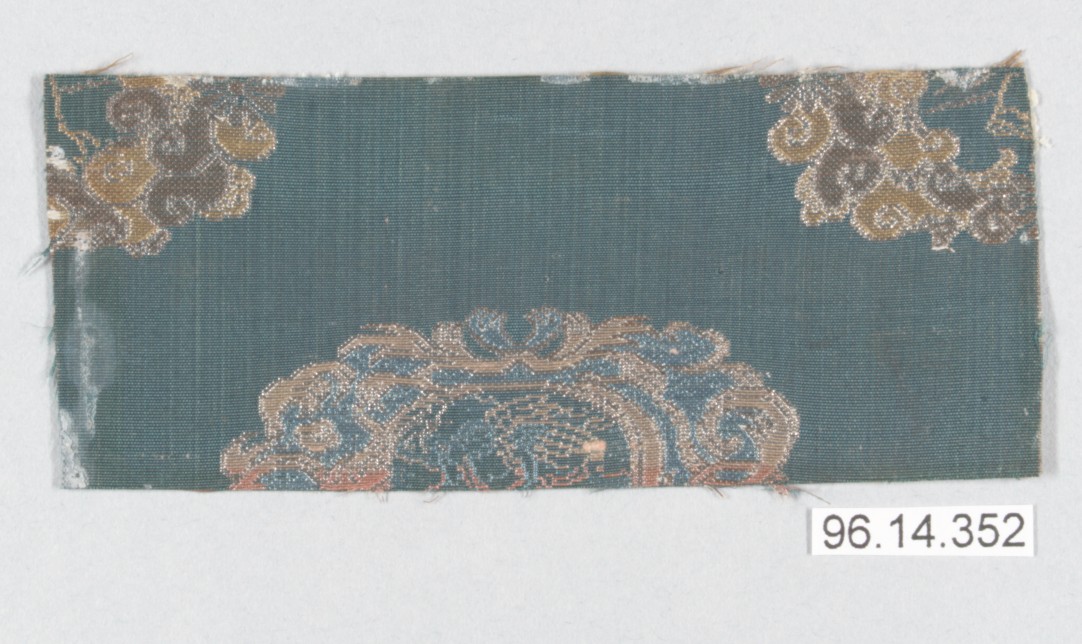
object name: piece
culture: japanese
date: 1701-1900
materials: silk